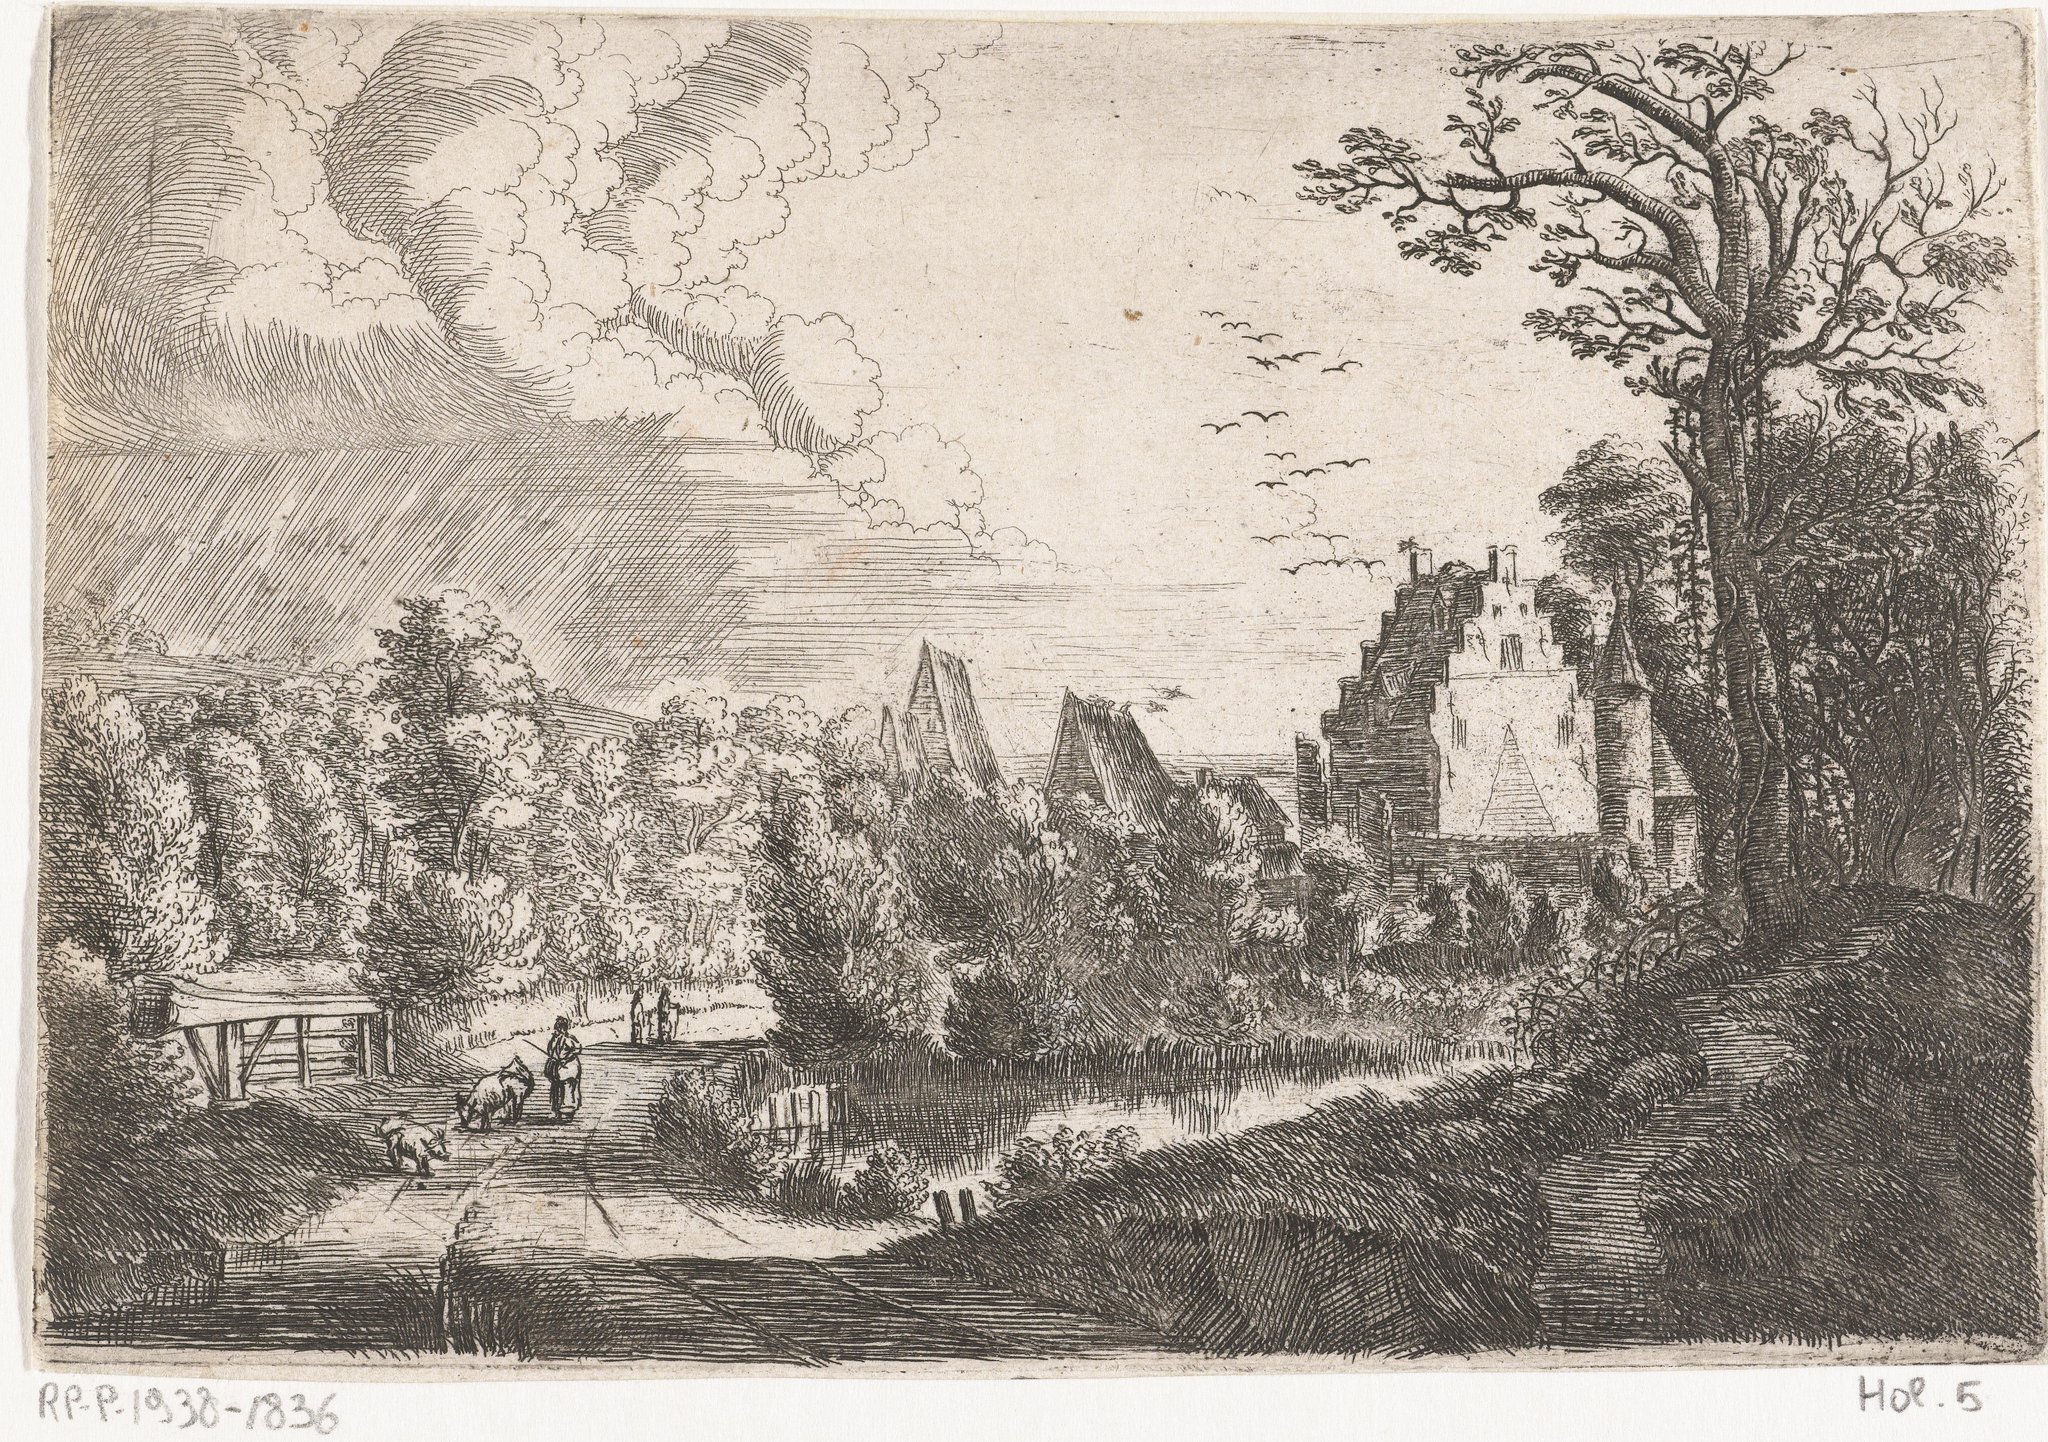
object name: print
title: Landschap met een kasteel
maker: jean baptiste bonnecroy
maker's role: print maker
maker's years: 1618-1676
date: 1628-1676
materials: paper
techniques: etching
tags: cow, castle, herding, herdsman, herdswoman, shepherd, shepherdess, cowherd, etc., meadow, pasture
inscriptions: collector's mark: Lugt 2228, collector's mark: Lugt 2760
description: Een landschap met een kasteel en enkele huizen op de achtergrond. Een zandweg maakt een bocht langs een rivier. Op de weg twee wandelaars en een herder met twee koeien.